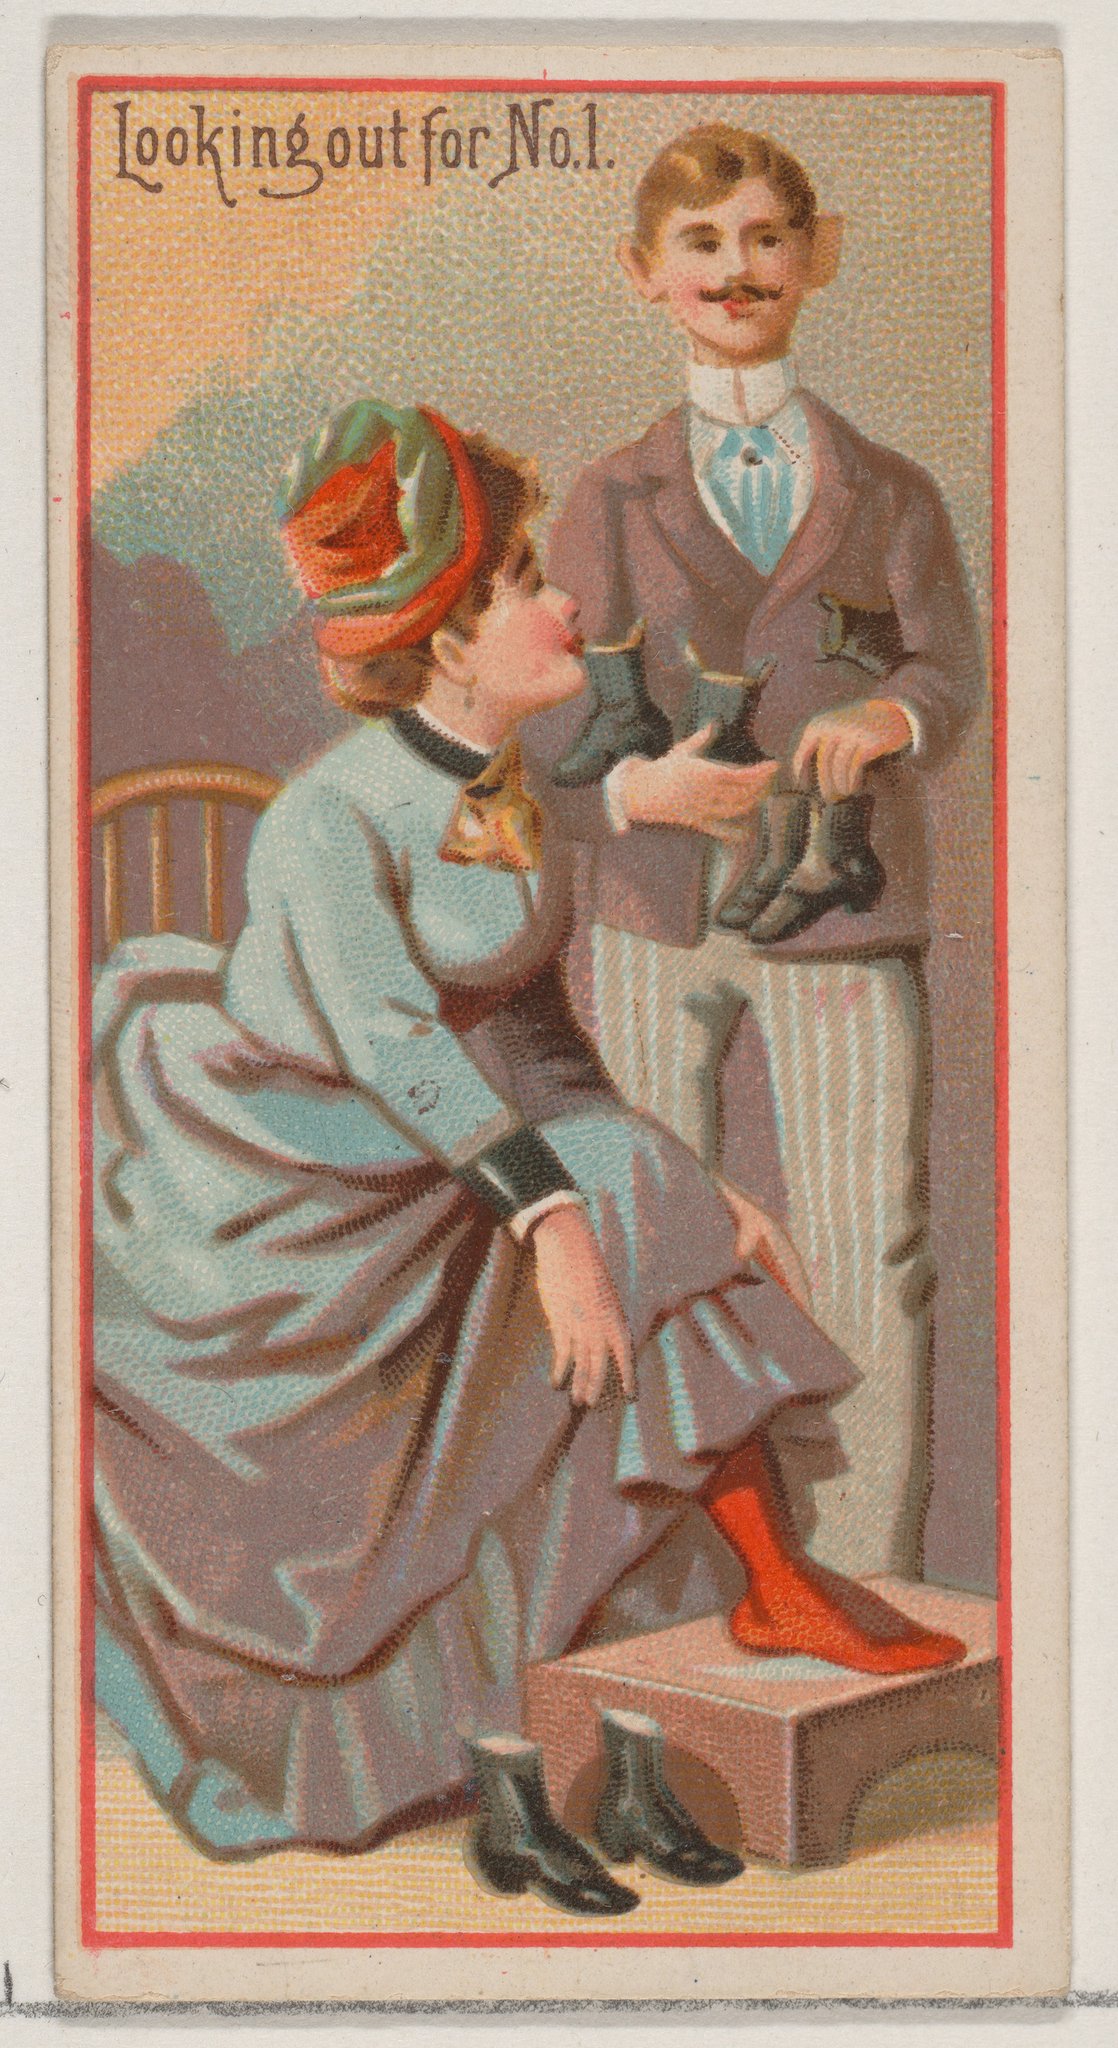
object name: print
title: Looking Out for Number One, from the Jokes series (N87) for Duke brand cigarettes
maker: w. duke, sons & co.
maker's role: publisher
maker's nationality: american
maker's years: 1870-1920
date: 1890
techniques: color lithograph